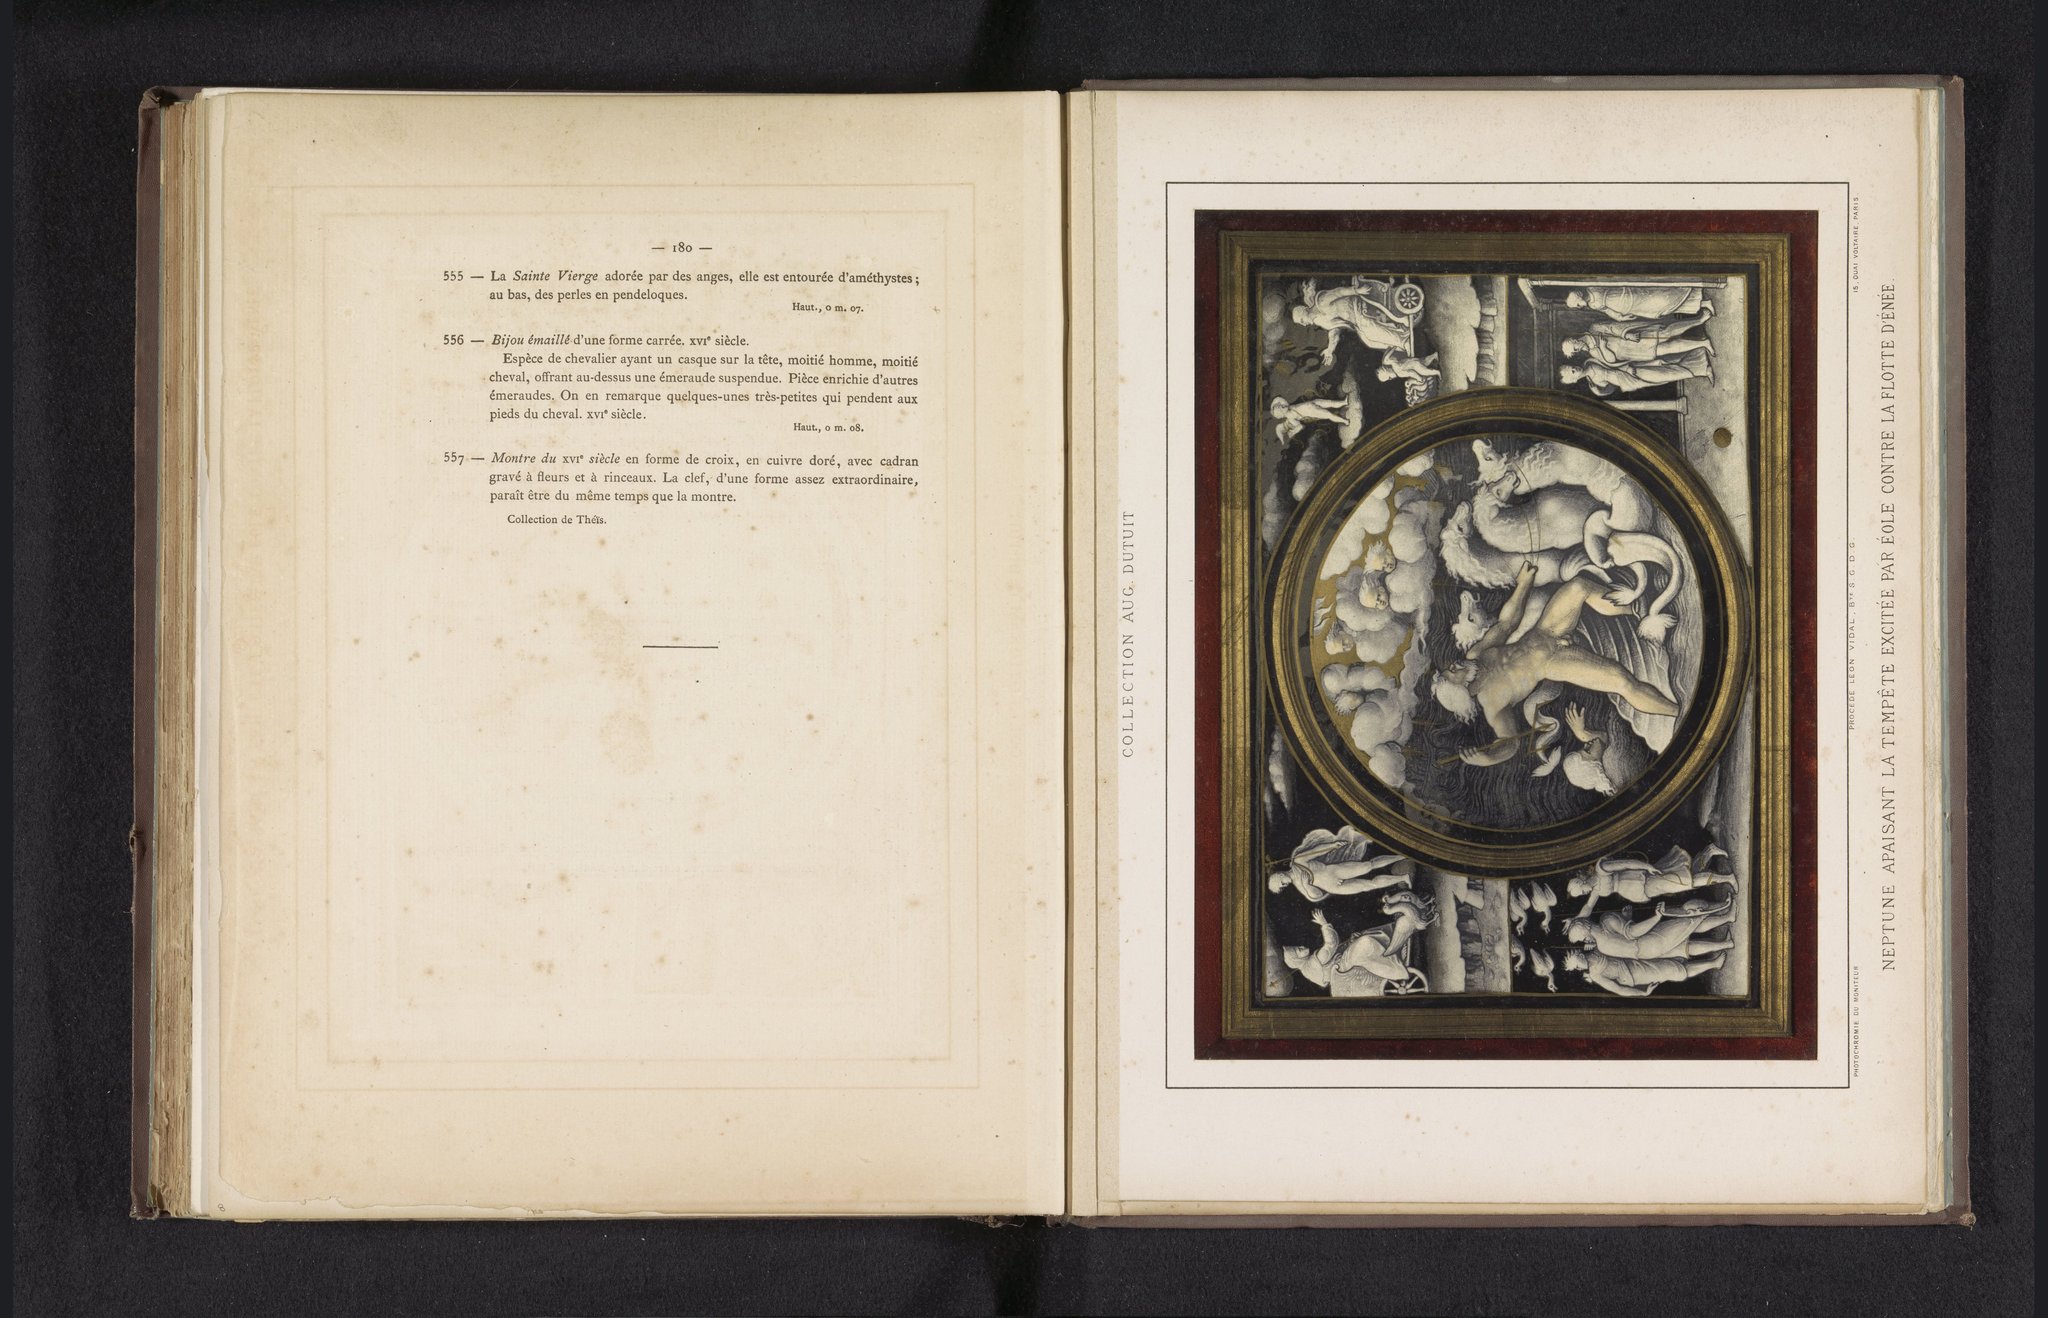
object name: photomechanical print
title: Neptunus die de storm stilt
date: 1879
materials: paper, photographic process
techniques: woodburytype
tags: (story of) neptune (poseidon)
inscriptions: inscription: ‘Photochromie du Moniteur 15, quai Voltaire, Paris’